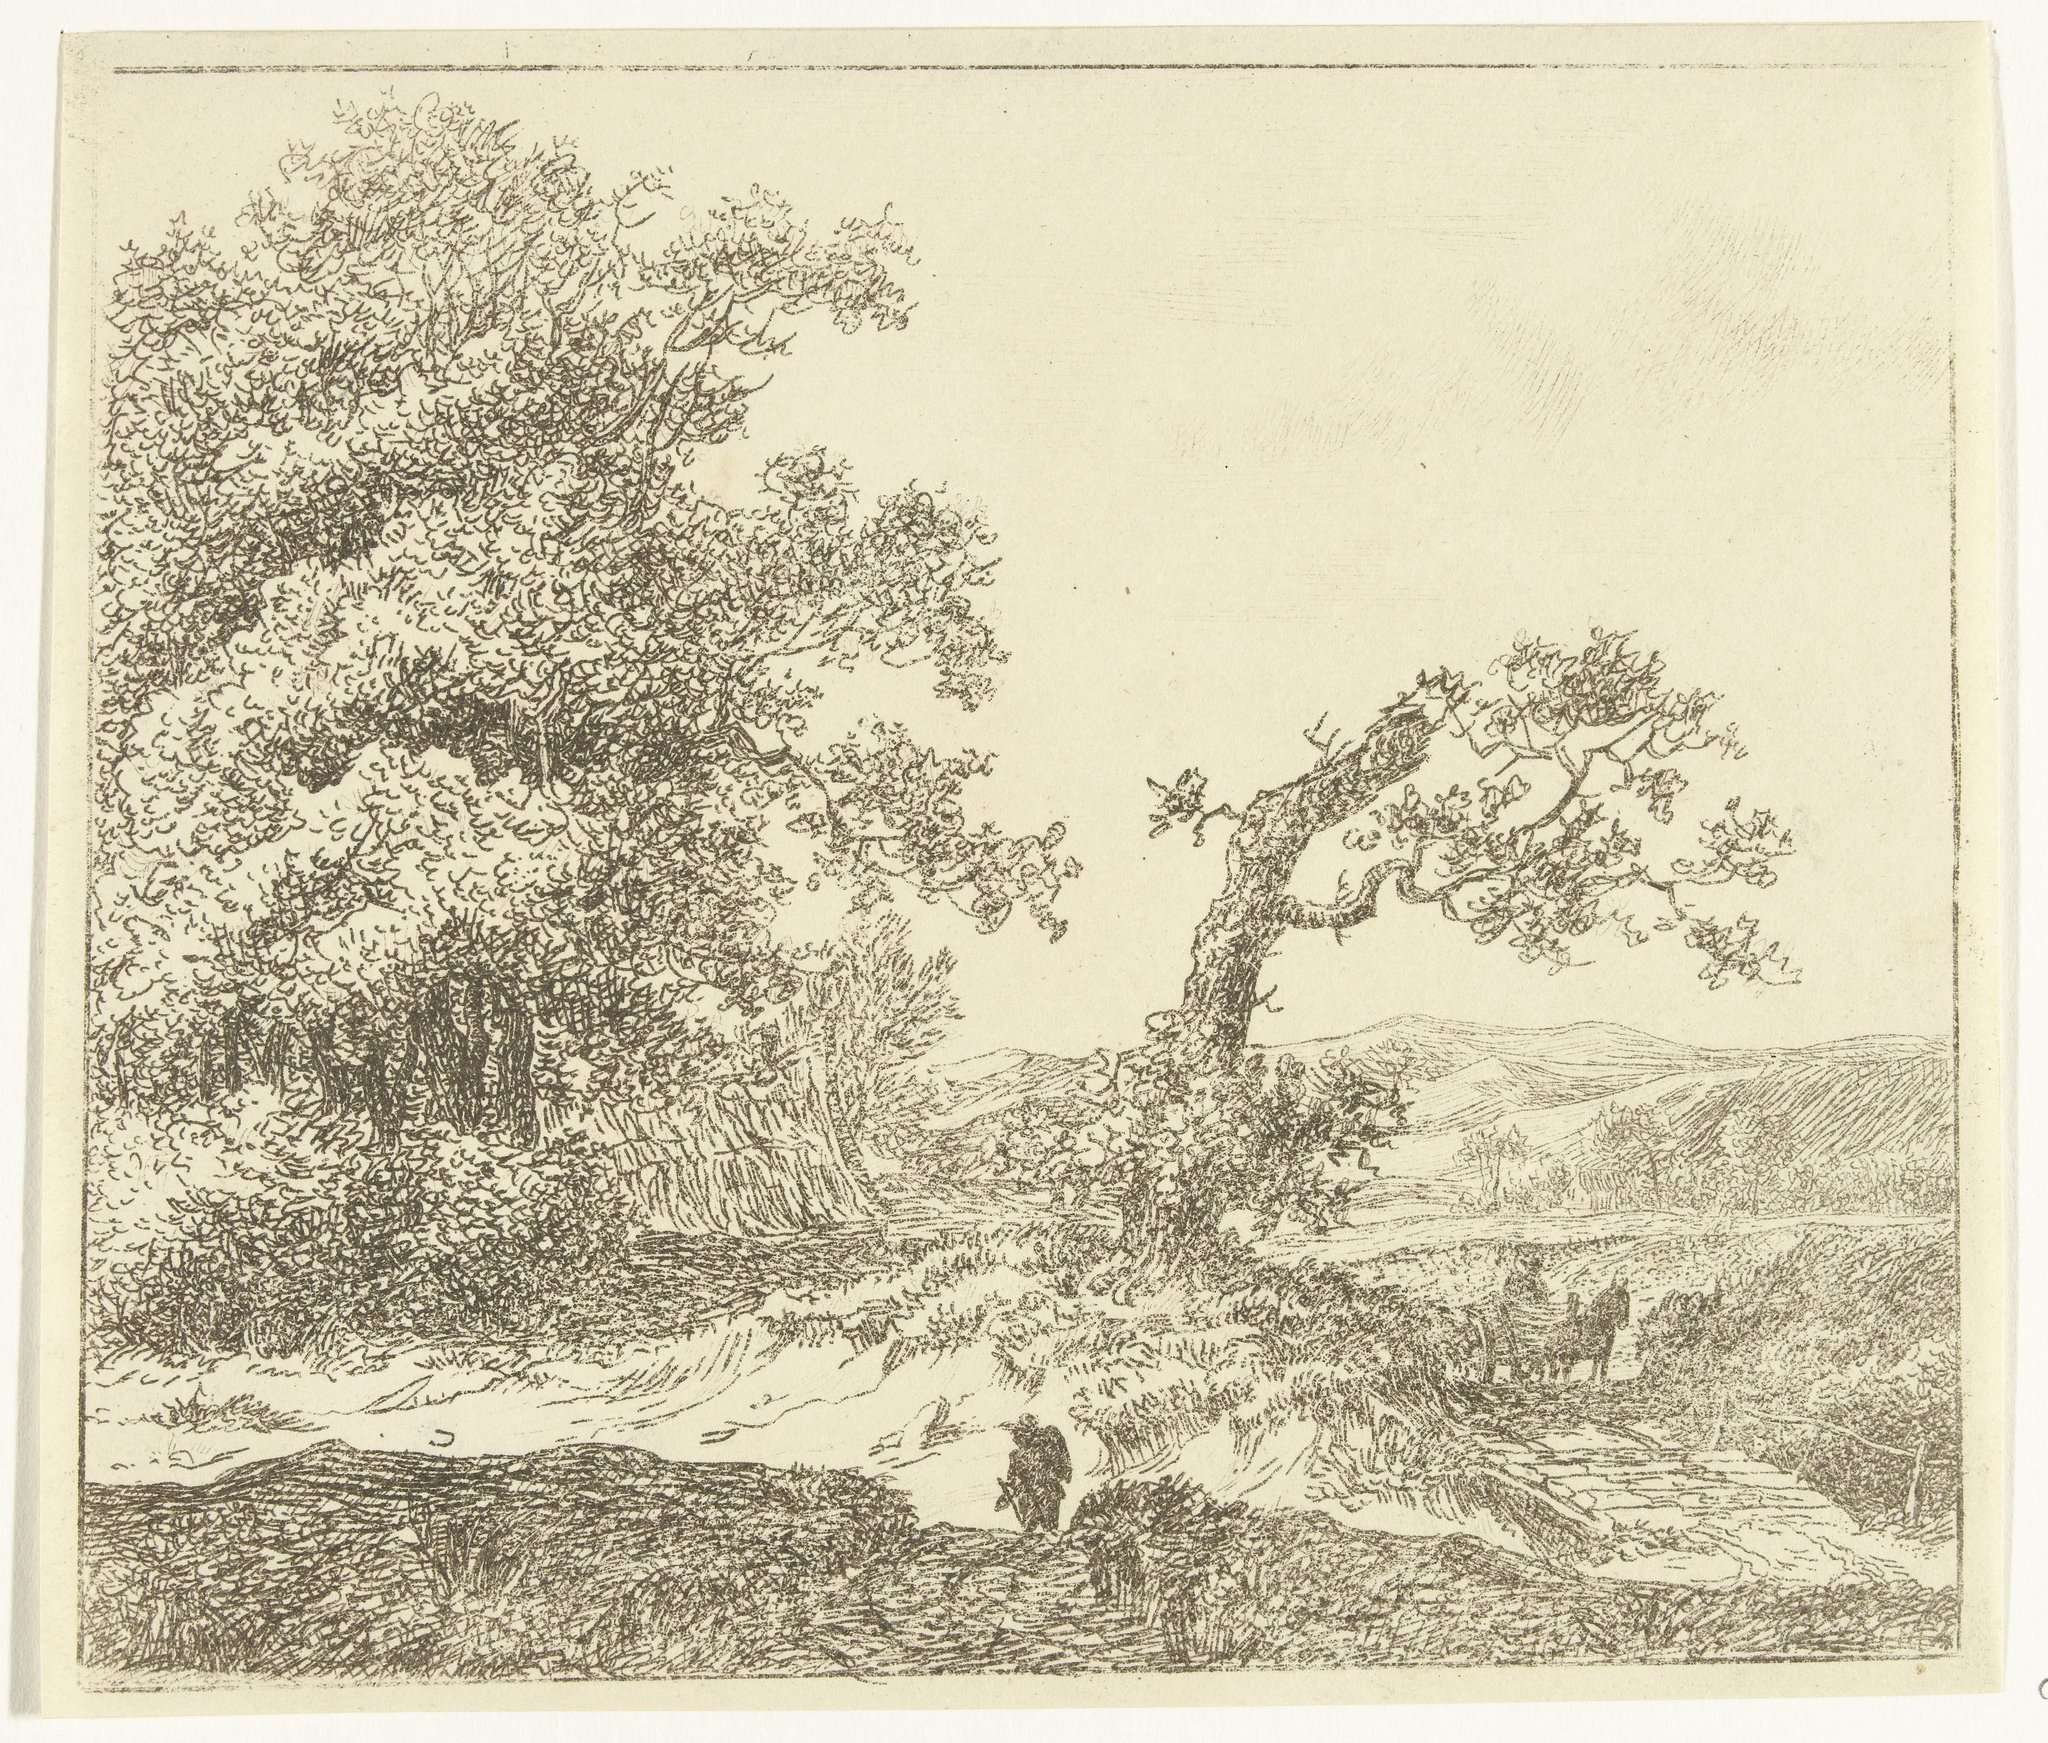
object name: print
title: Wandelaar in de duinen buite Haarlem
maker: anthonie van den bos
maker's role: draughtsman, print maker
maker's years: 1763-1838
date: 1778-1838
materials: paper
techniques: printmaking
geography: netherlands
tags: dunes (sea not visible); in the dunes, haarlem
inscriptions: collector's mark: Lugt 2228